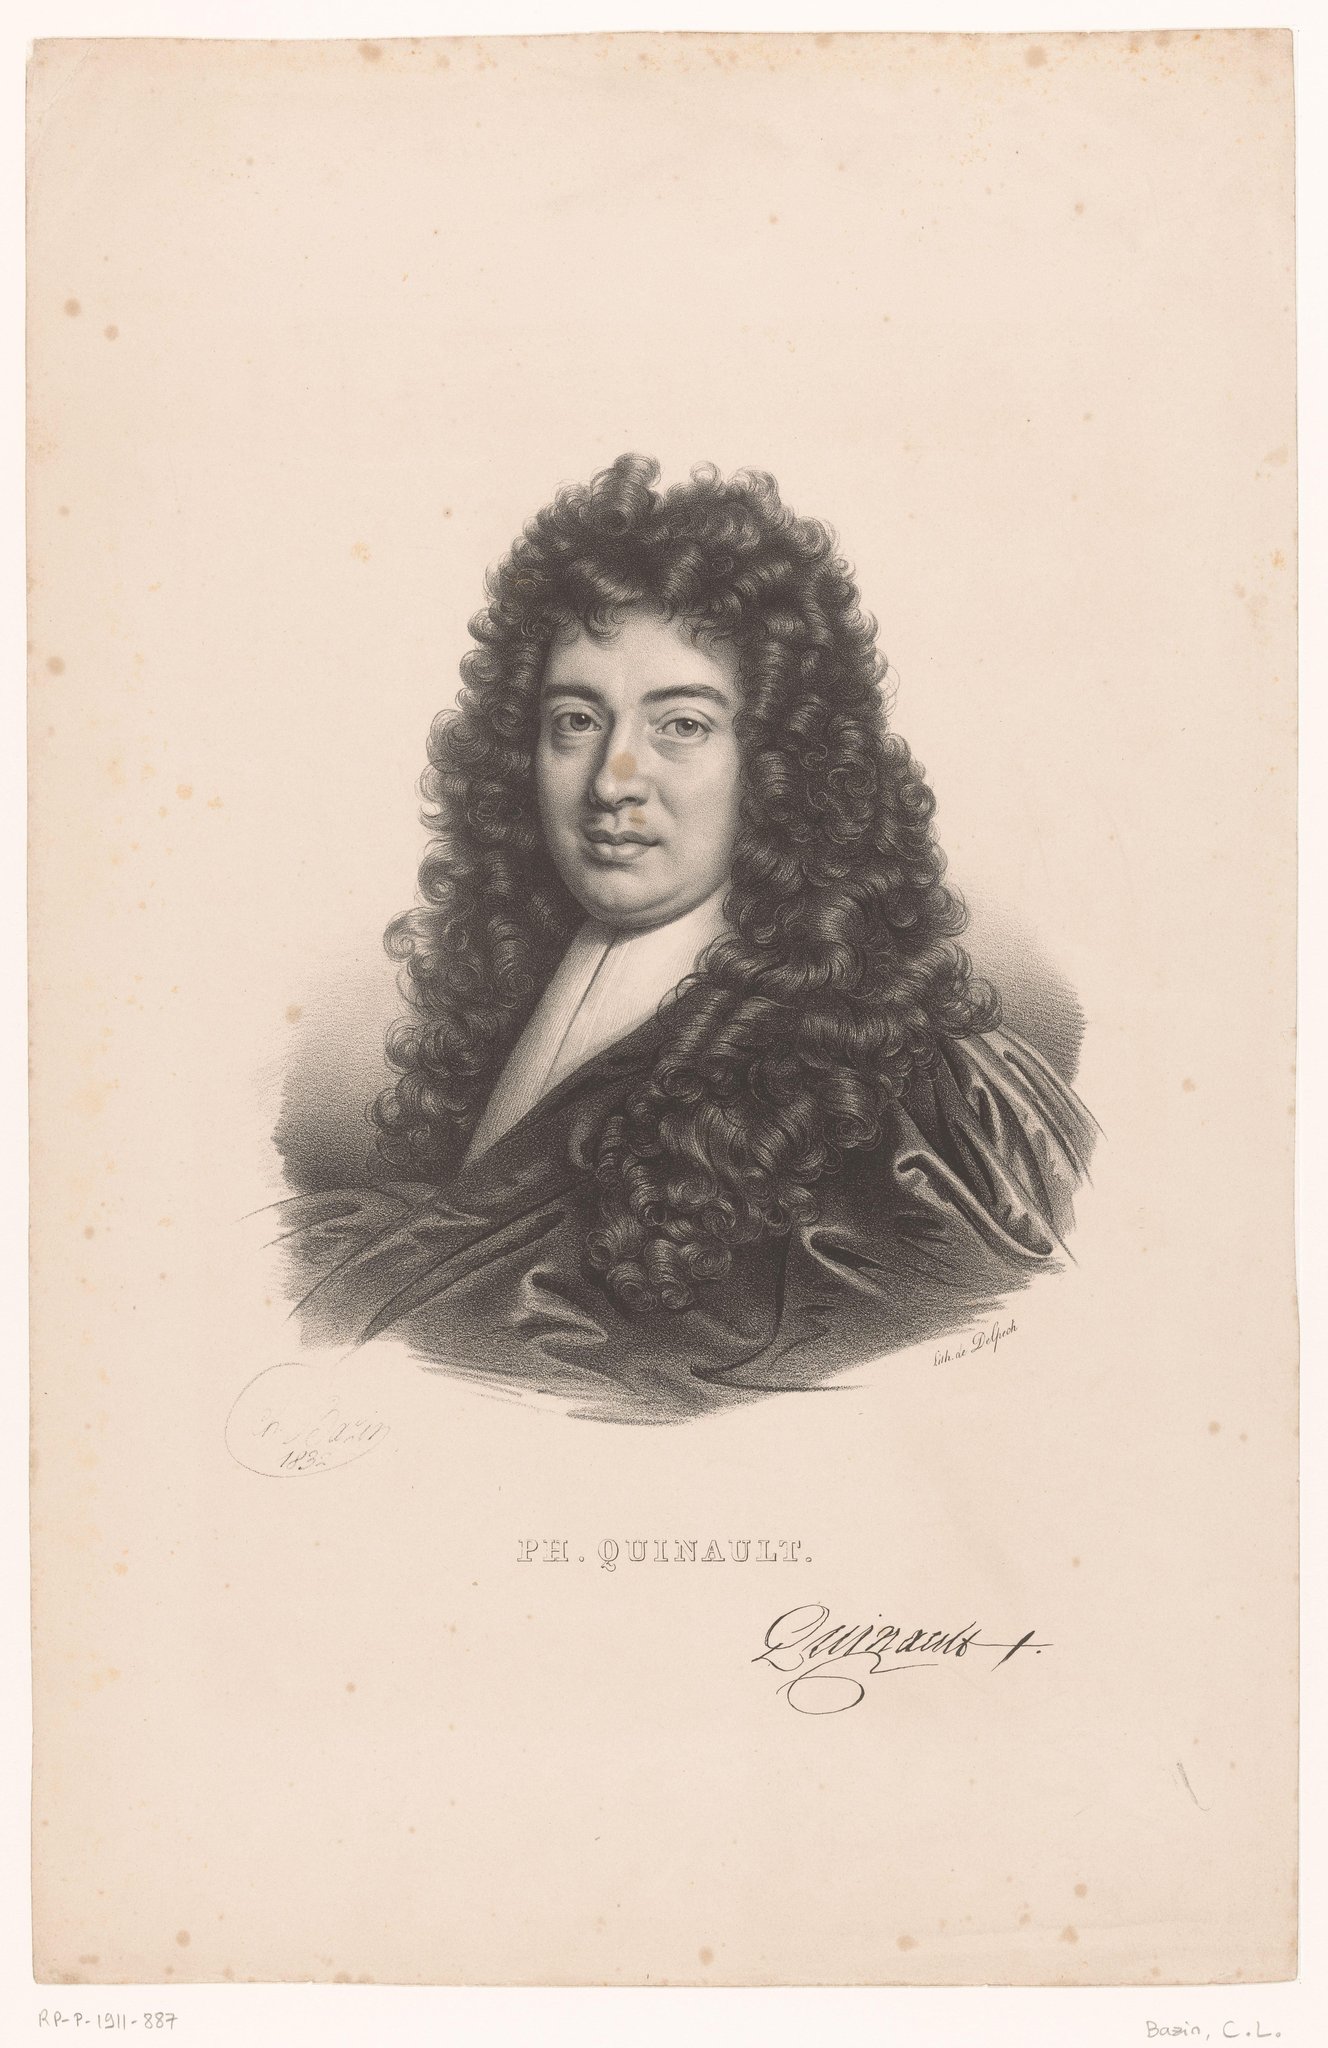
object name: print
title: Ph. Quinault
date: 1832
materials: paper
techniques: lithograph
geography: paris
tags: paris, historical persons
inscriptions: collector's mark: Lugt 2228a